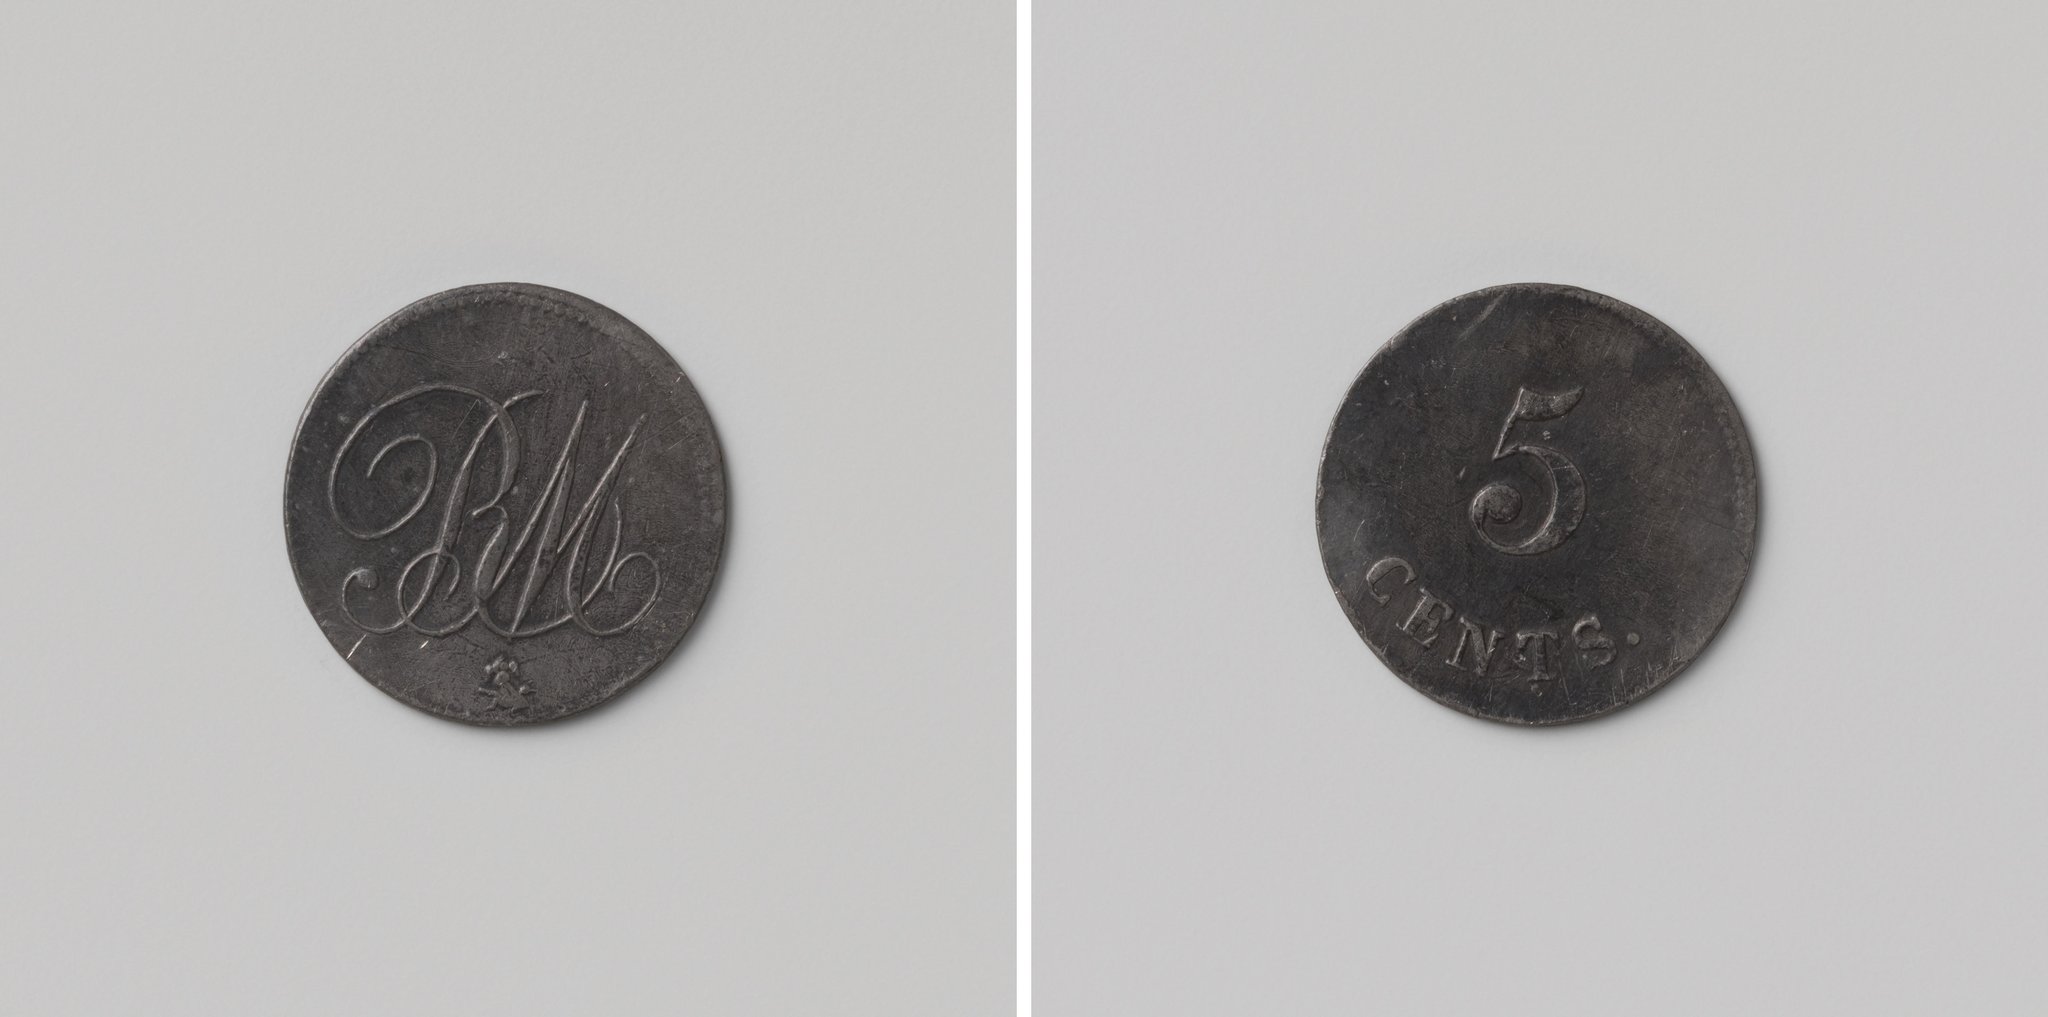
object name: huismunt prison money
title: Huismunt van de kolo9nies Rijkevorsel en Merksplas ter waarde van vijf cent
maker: Anonymous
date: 1823-1839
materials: zinc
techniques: striking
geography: brussels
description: Zinken munt. Voorzijde: monogram van letters R en M boven merktekentje. Keerzijde: waardeaanduiding.